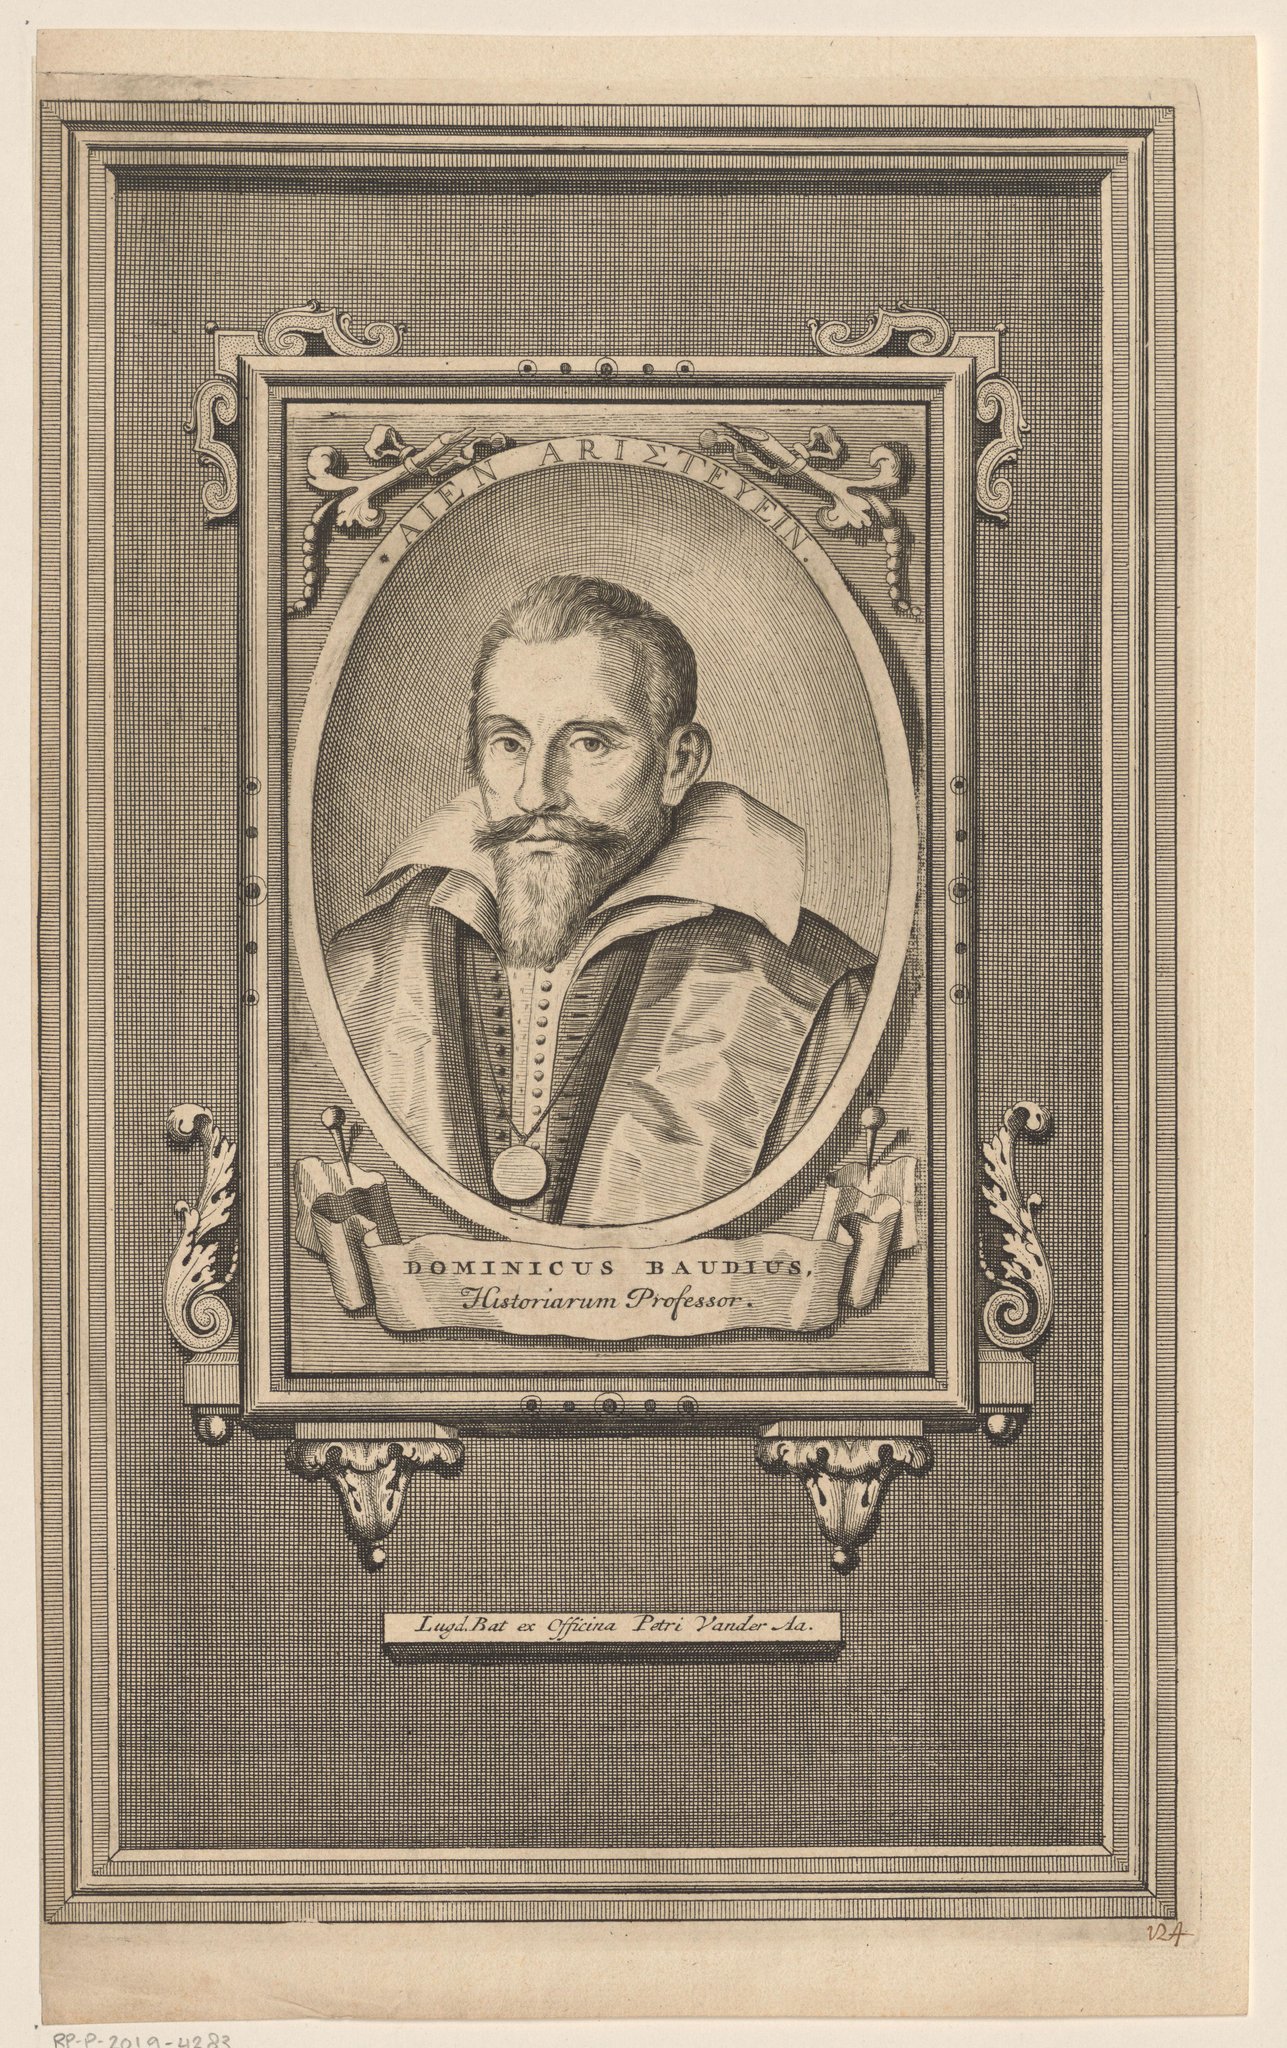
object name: print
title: Portret van Dominicus Baudius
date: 1716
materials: paper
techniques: engraving, etching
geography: leiden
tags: lille, leiden, dominicus baudius, historical persons, writer, poet, author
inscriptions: inscription: ‘124’